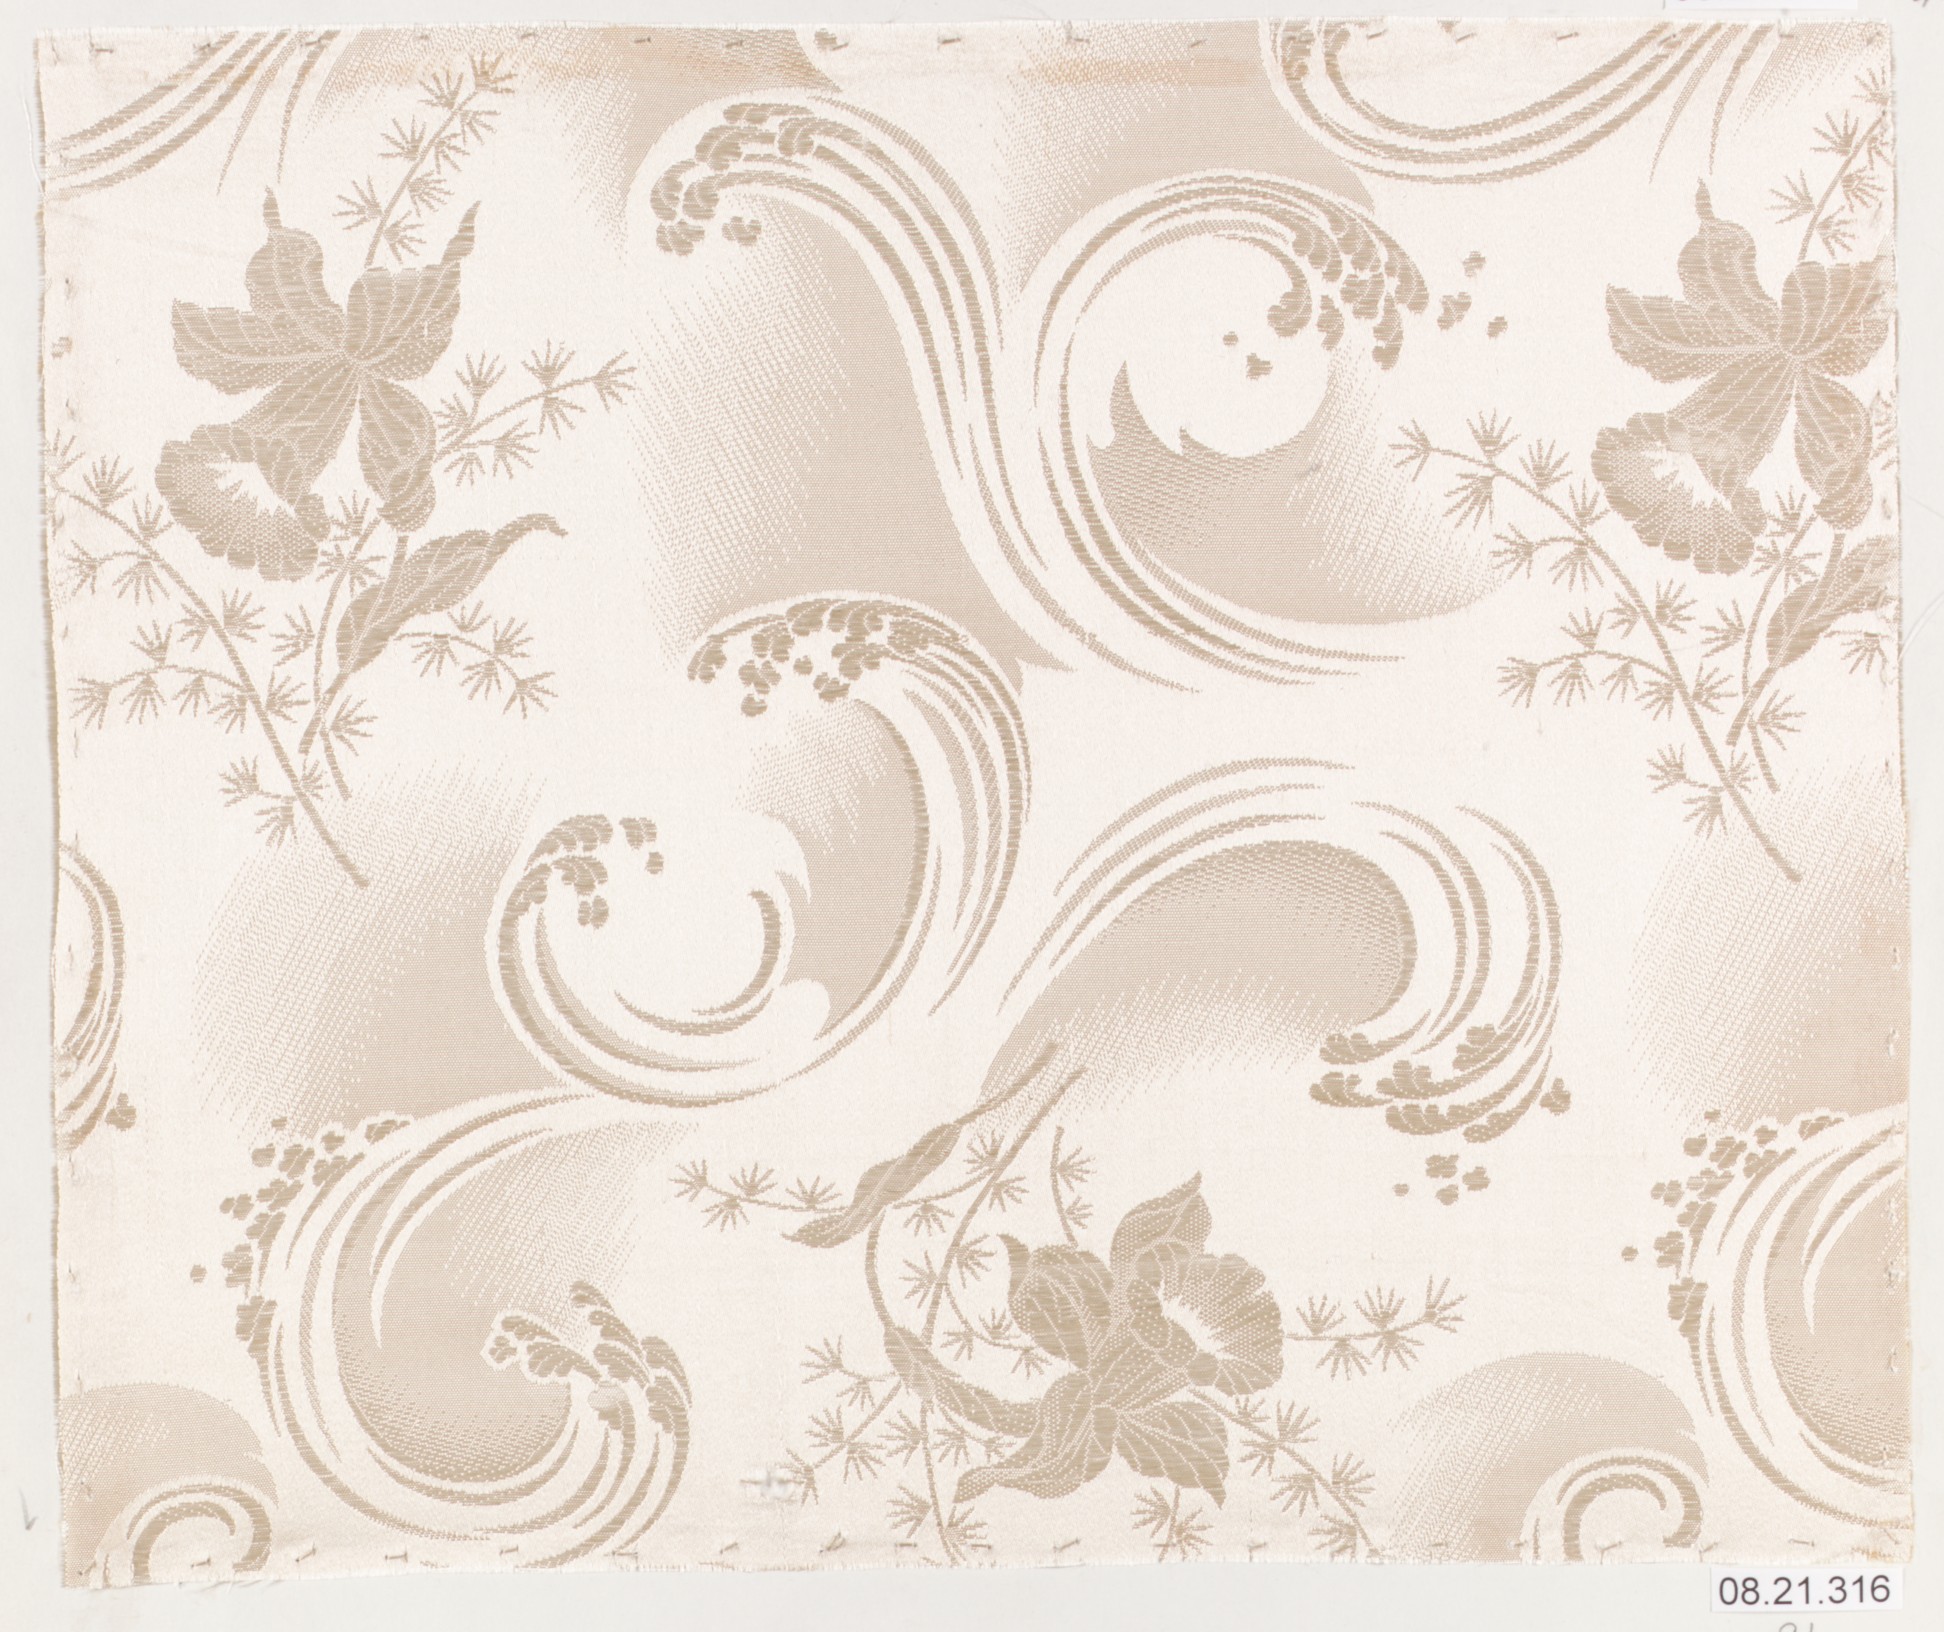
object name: textile sample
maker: Anonymous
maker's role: designer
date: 1900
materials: silk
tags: flowers